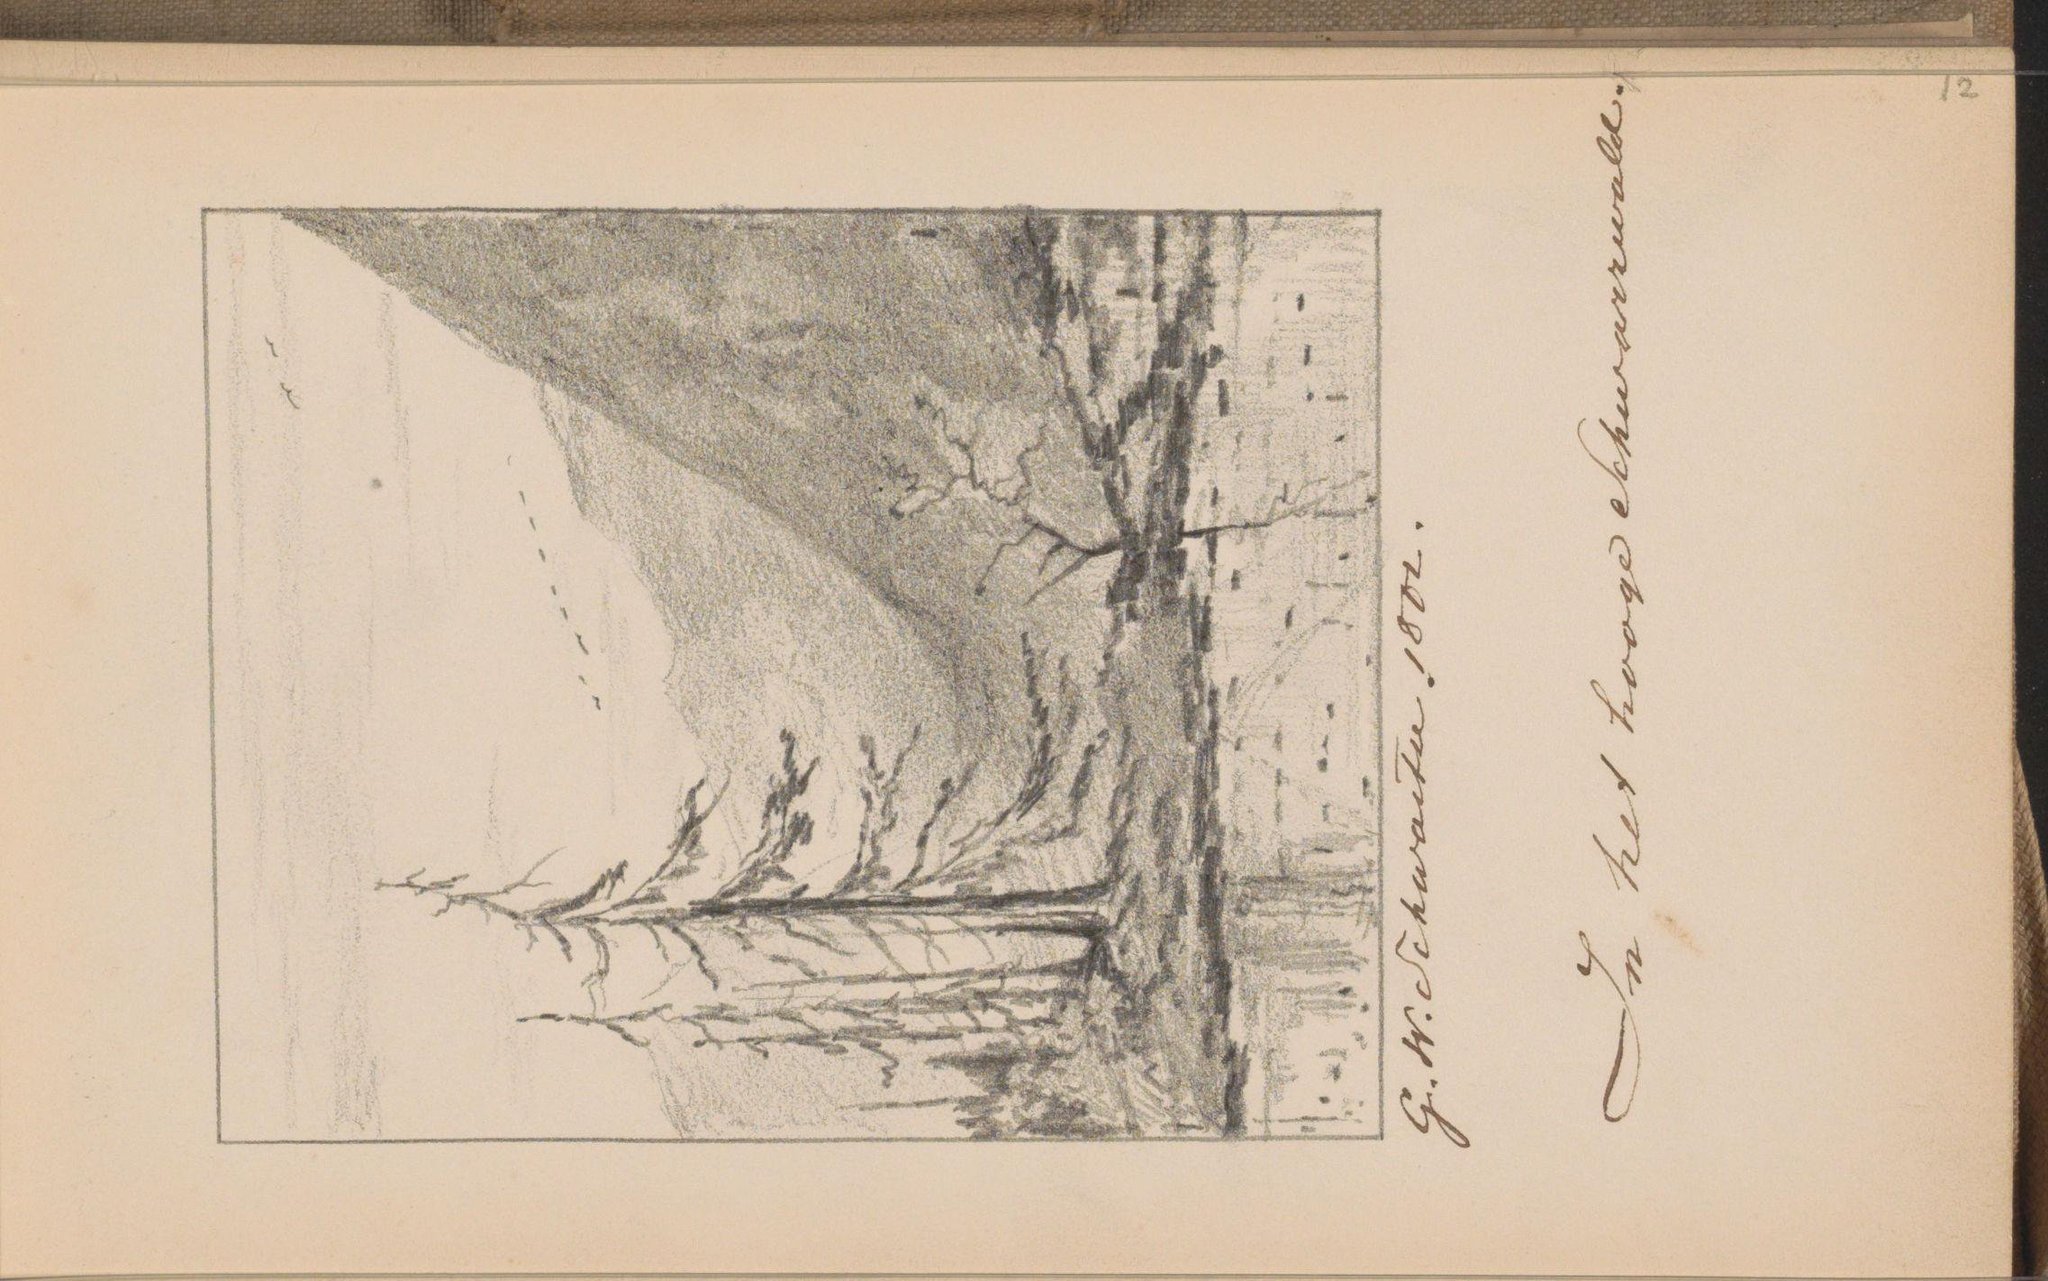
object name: sketchbook leaf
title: Landschap in het Hoge Zwarte Woud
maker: george washington schwartze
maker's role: draughtsman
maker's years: 1857-1909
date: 1882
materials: paper, pencil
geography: schwarzwald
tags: landscapes with waters, waterscapes, seascapes (in the temperate zone), mountains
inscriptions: title: ‘In het hooge Schwarzwald.’, signature and date: ‘G.W.Schwartze. 1882.’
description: Tekening in een kader. Blad 12 recto uit een schetsboek met 54 bladen.